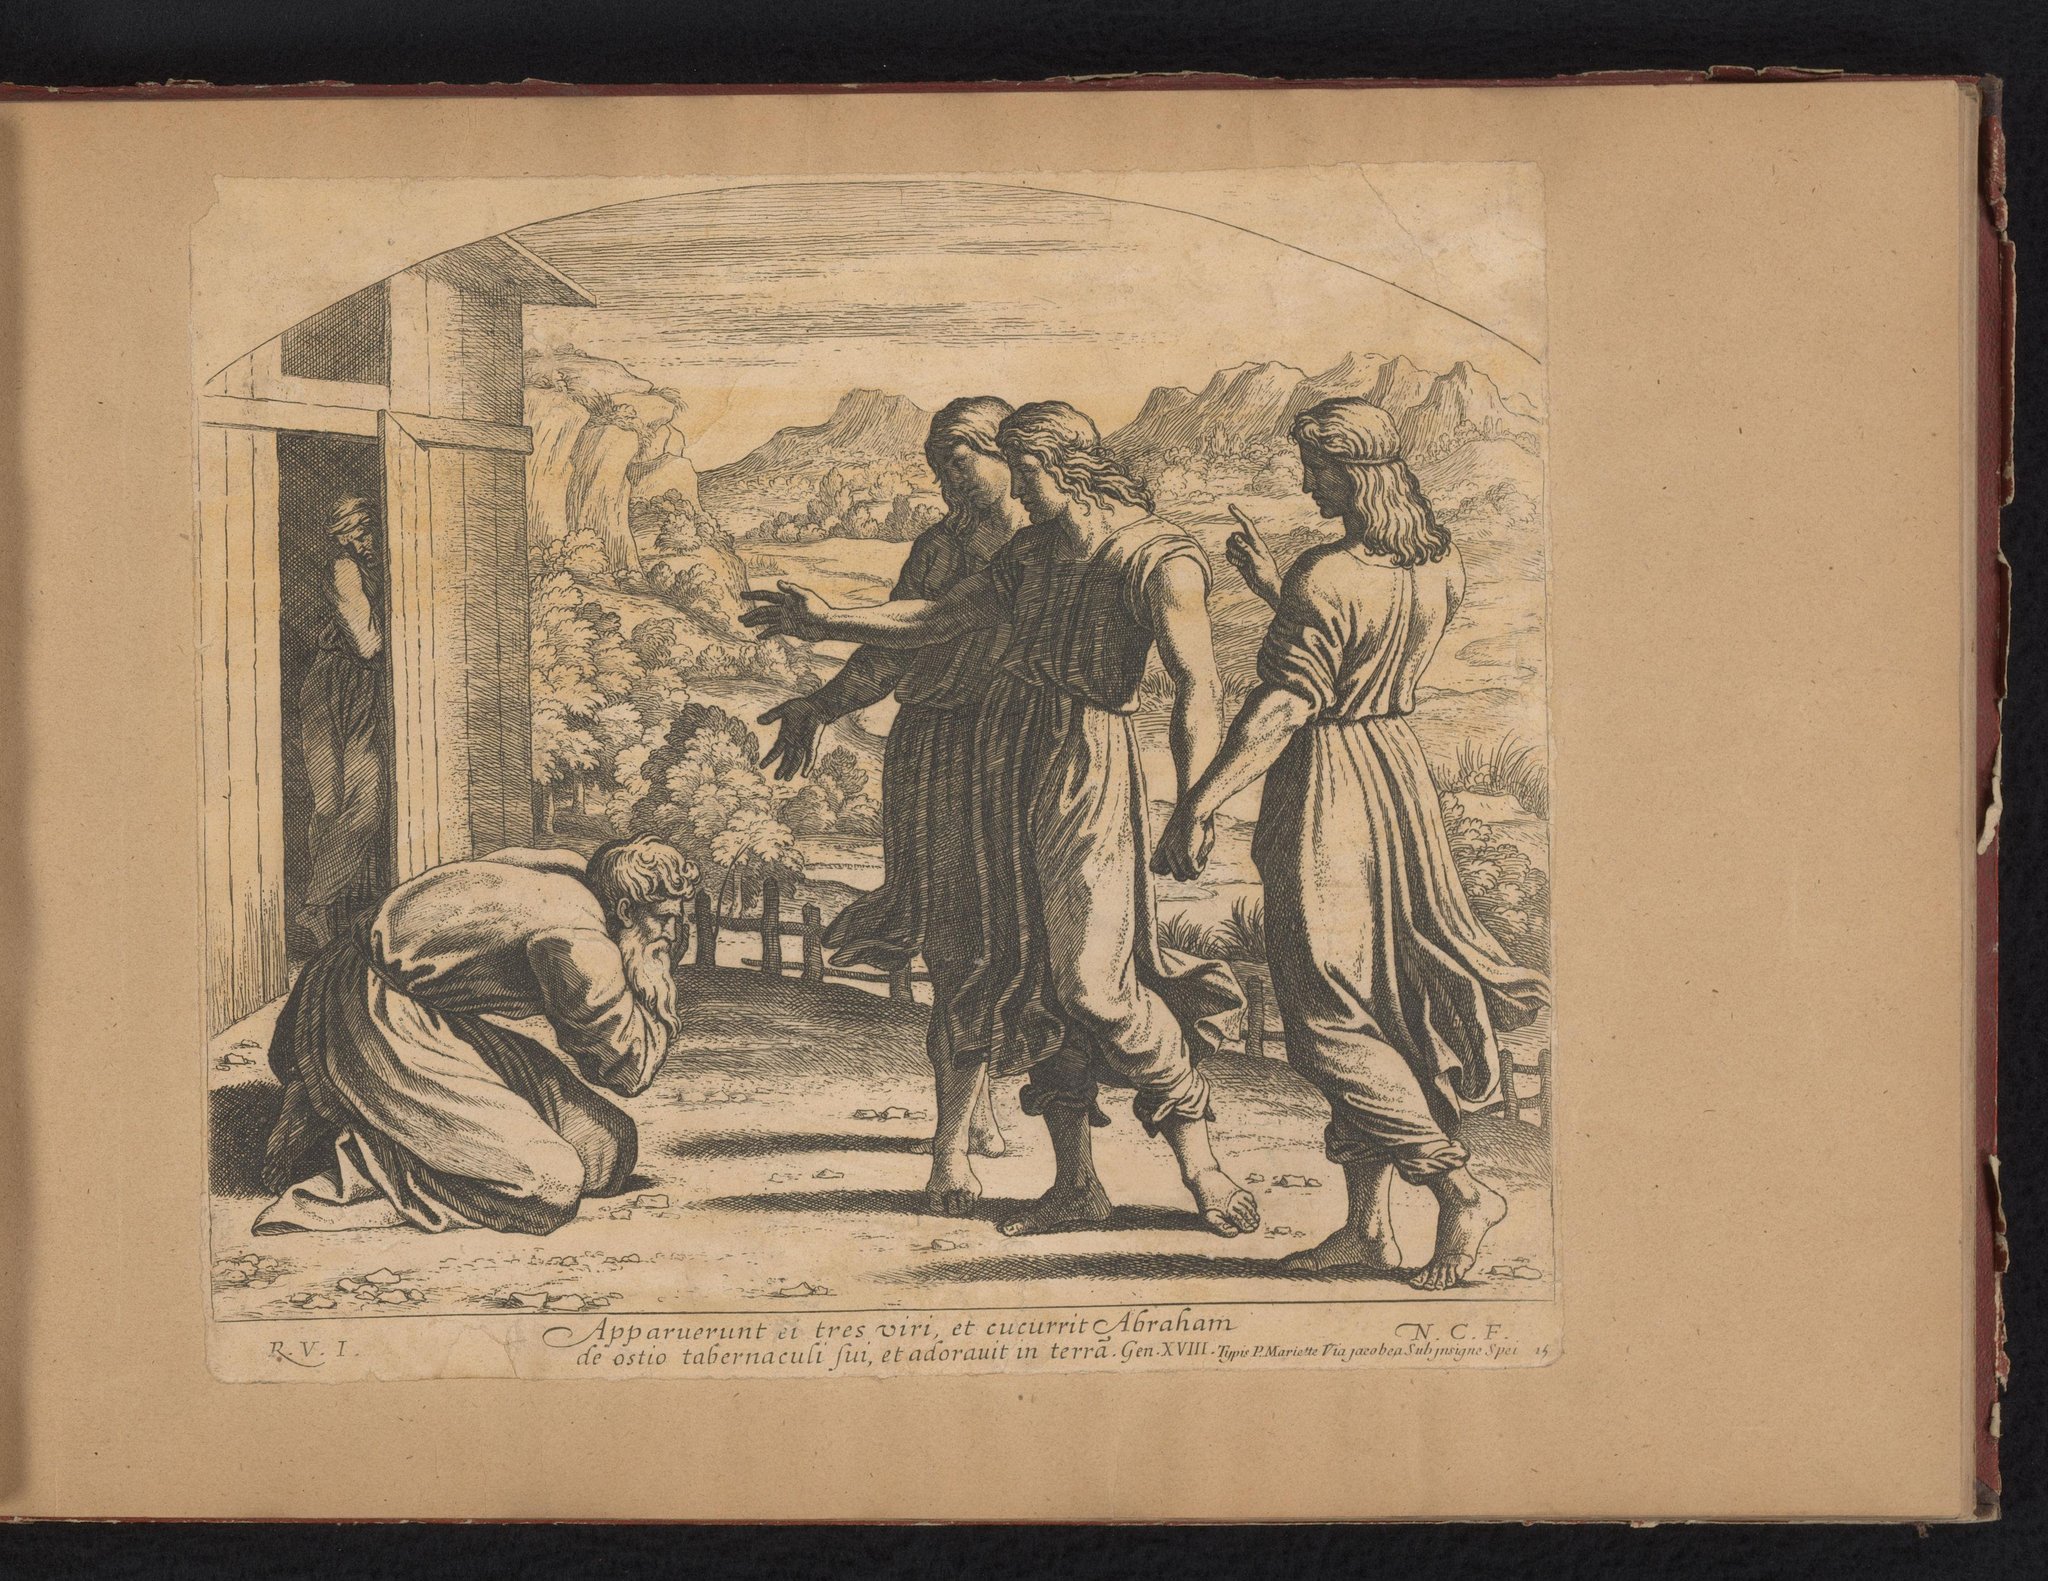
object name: album leaf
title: God verschijnt aan Abraham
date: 1649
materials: paper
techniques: etching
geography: paris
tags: god promises that abraham's seed shall be as numerous as the stars of heaven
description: Deze prent maakt deel uit van een album.